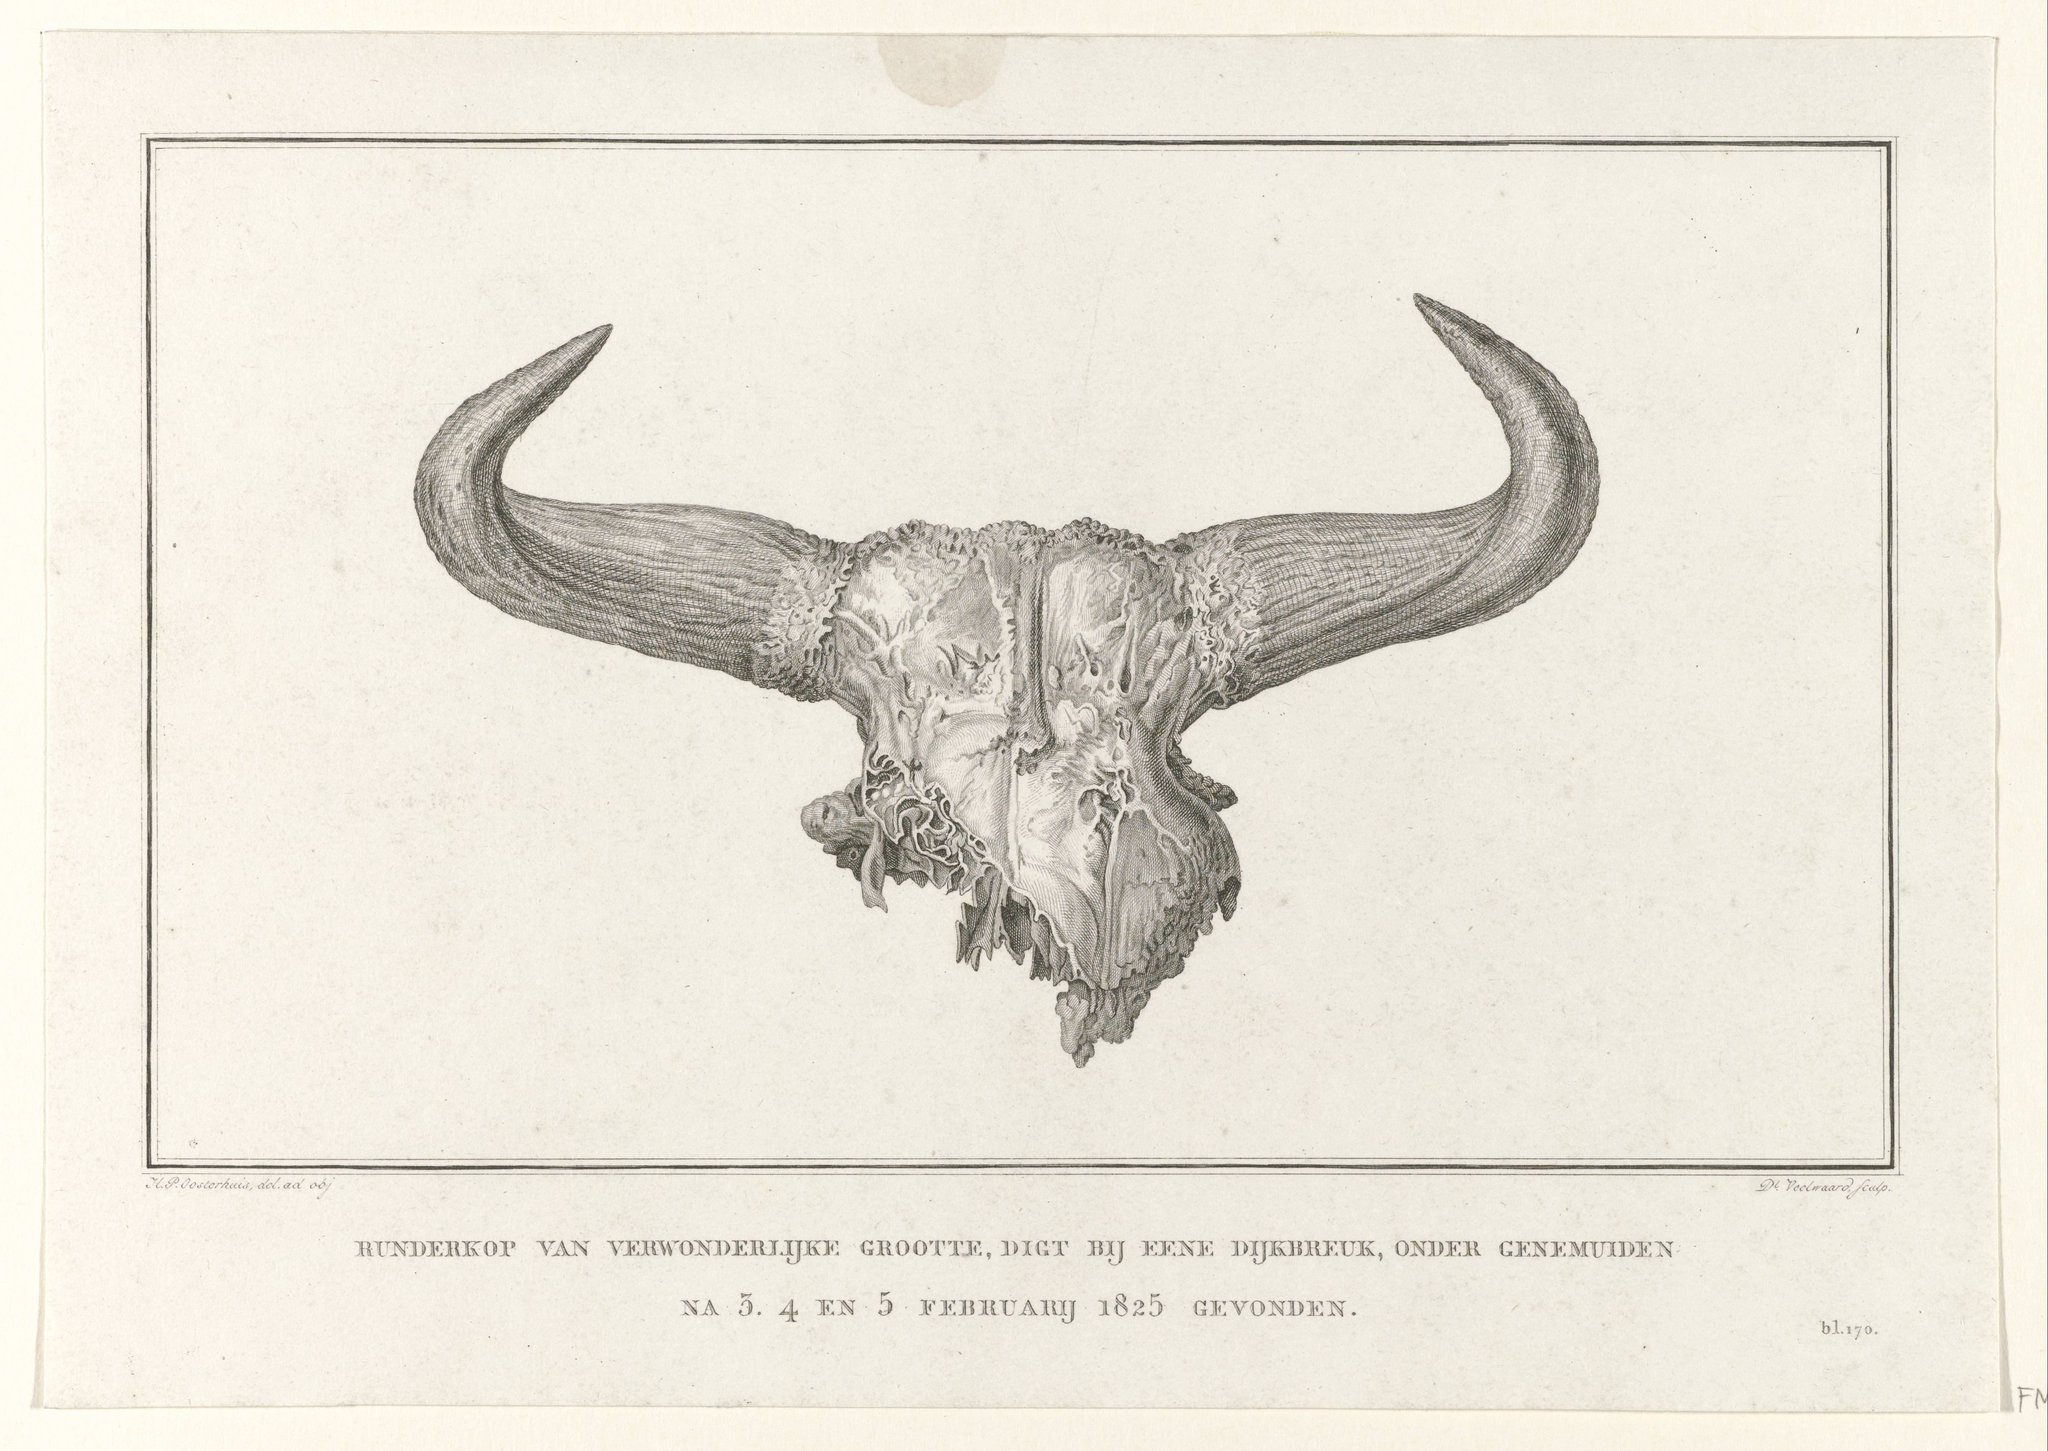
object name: print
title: Runderschedel, 1825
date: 1825-1826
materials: paper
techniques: engraving, etching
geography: netherlands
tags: fossil animals, flood, bovine cattle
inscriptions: collector's mark: Lugt 2228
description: Gebruikt als illustratie in: Nicolaas Swart, Historisch tafereel van den zwaren watersnood, op den 3den, 4den en 5den Februarij 1825, een groot deel van ons vaderland hebbende getroffen. Amsterdam : bij Schalekamp en Van de Grampel, 1826, p. 170.